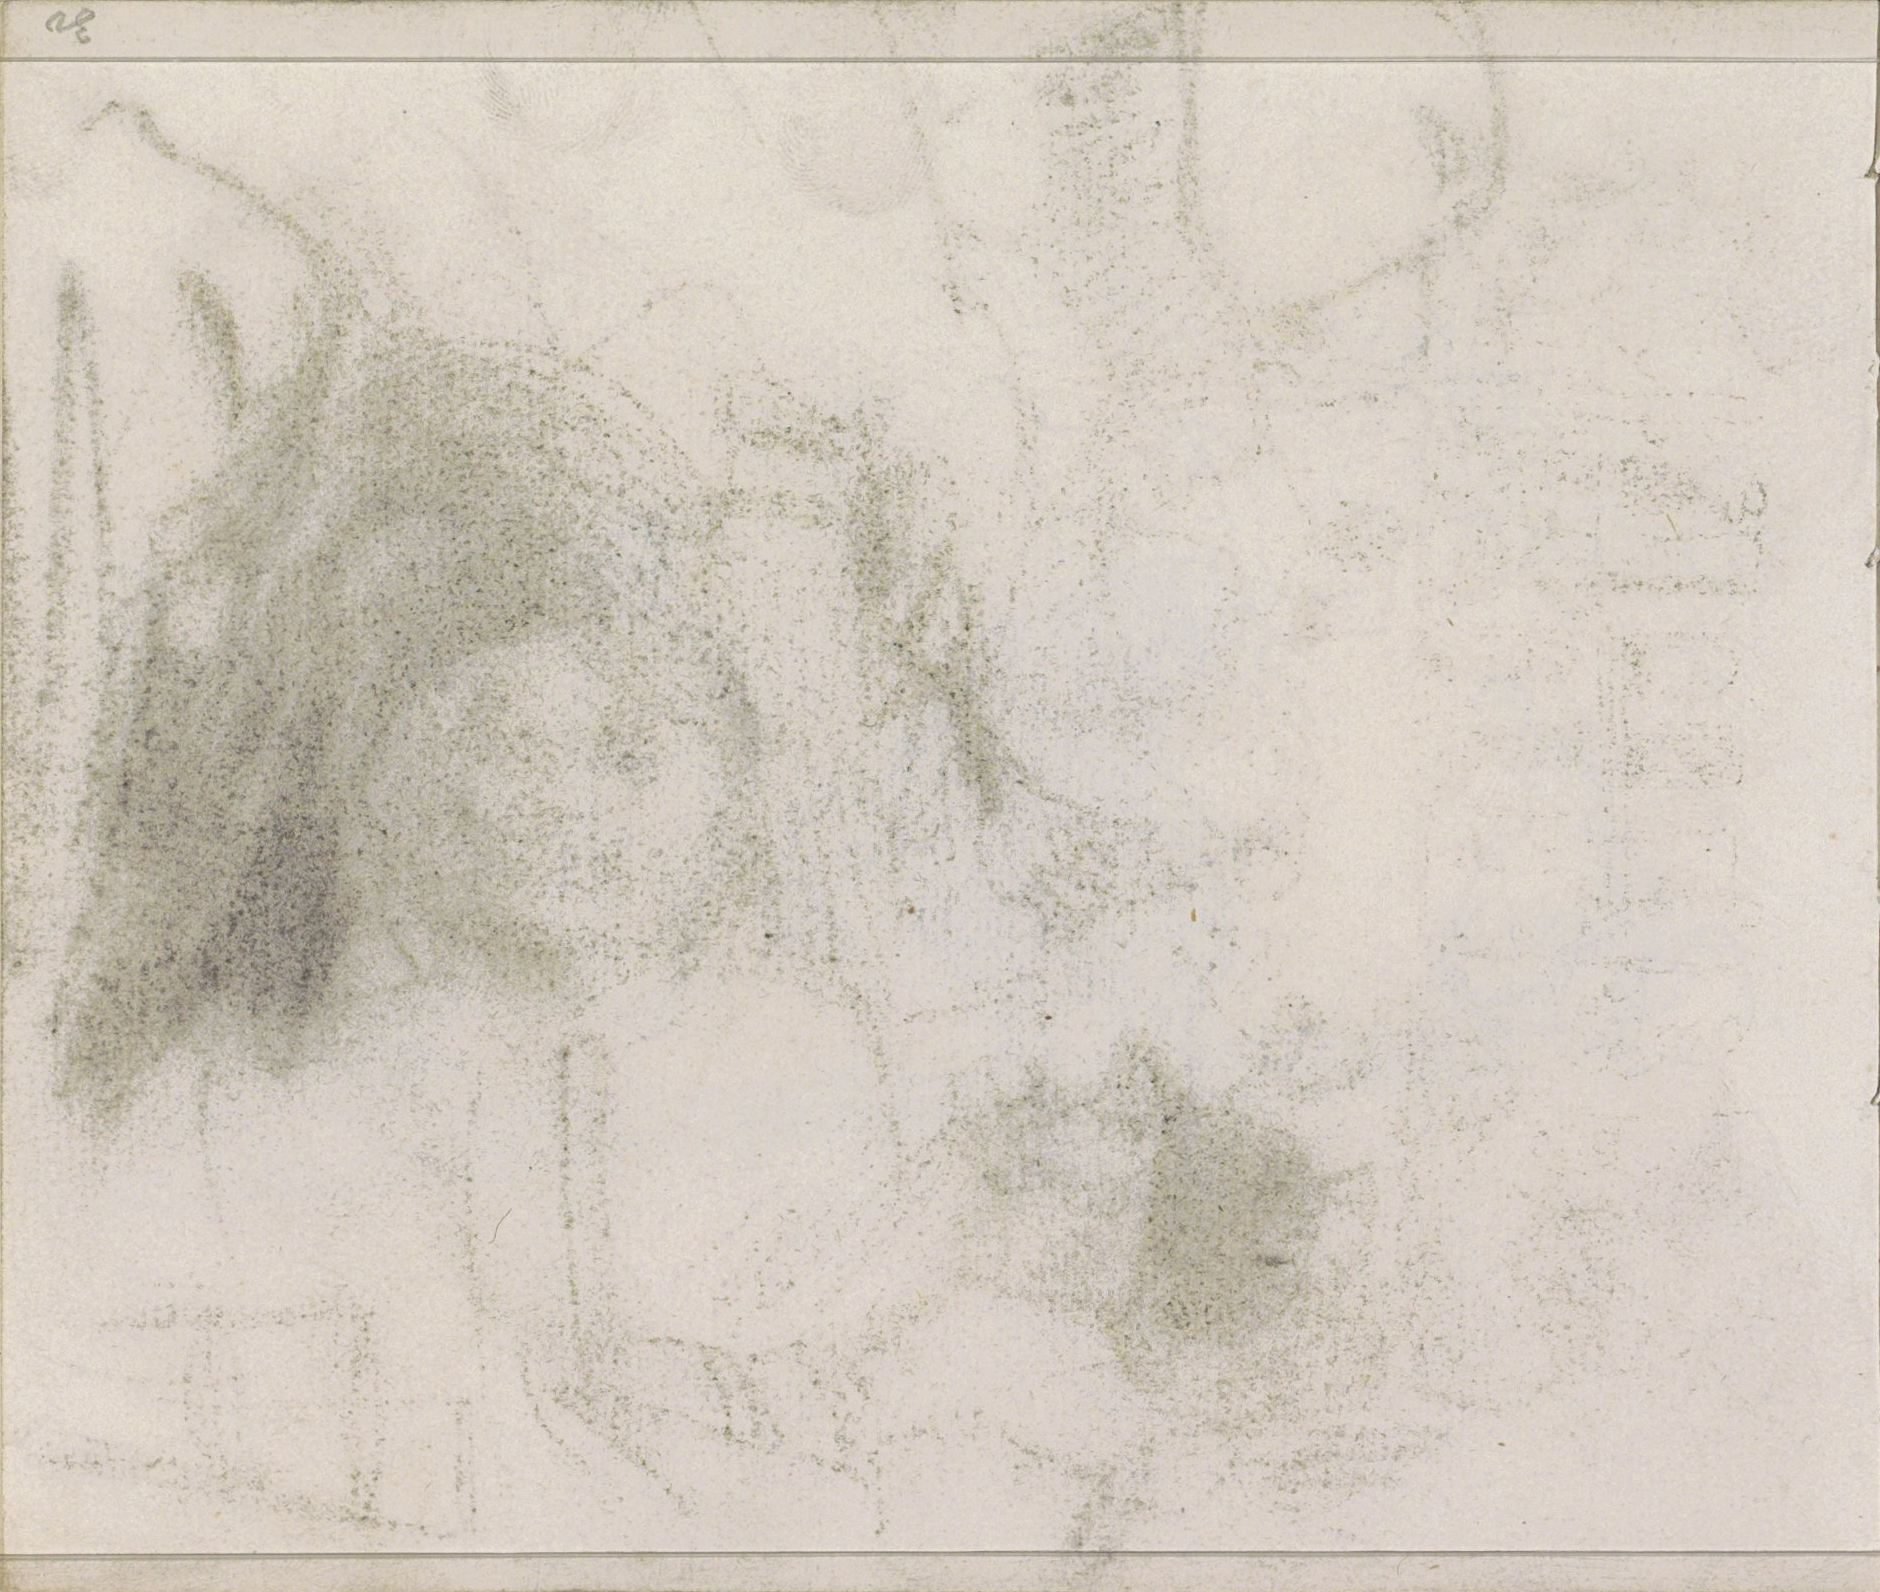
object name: sketchbook leaf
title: Abklatsch van de krijttekening op blad 8 recto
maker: isaac israels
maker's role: draughtsman, painter, print maker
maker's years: 1865-1934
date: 1886-1934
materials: paper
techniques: printmaking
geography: amsterdam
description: Blad 7 verso uit schetsboek LIV met 18 bladen.